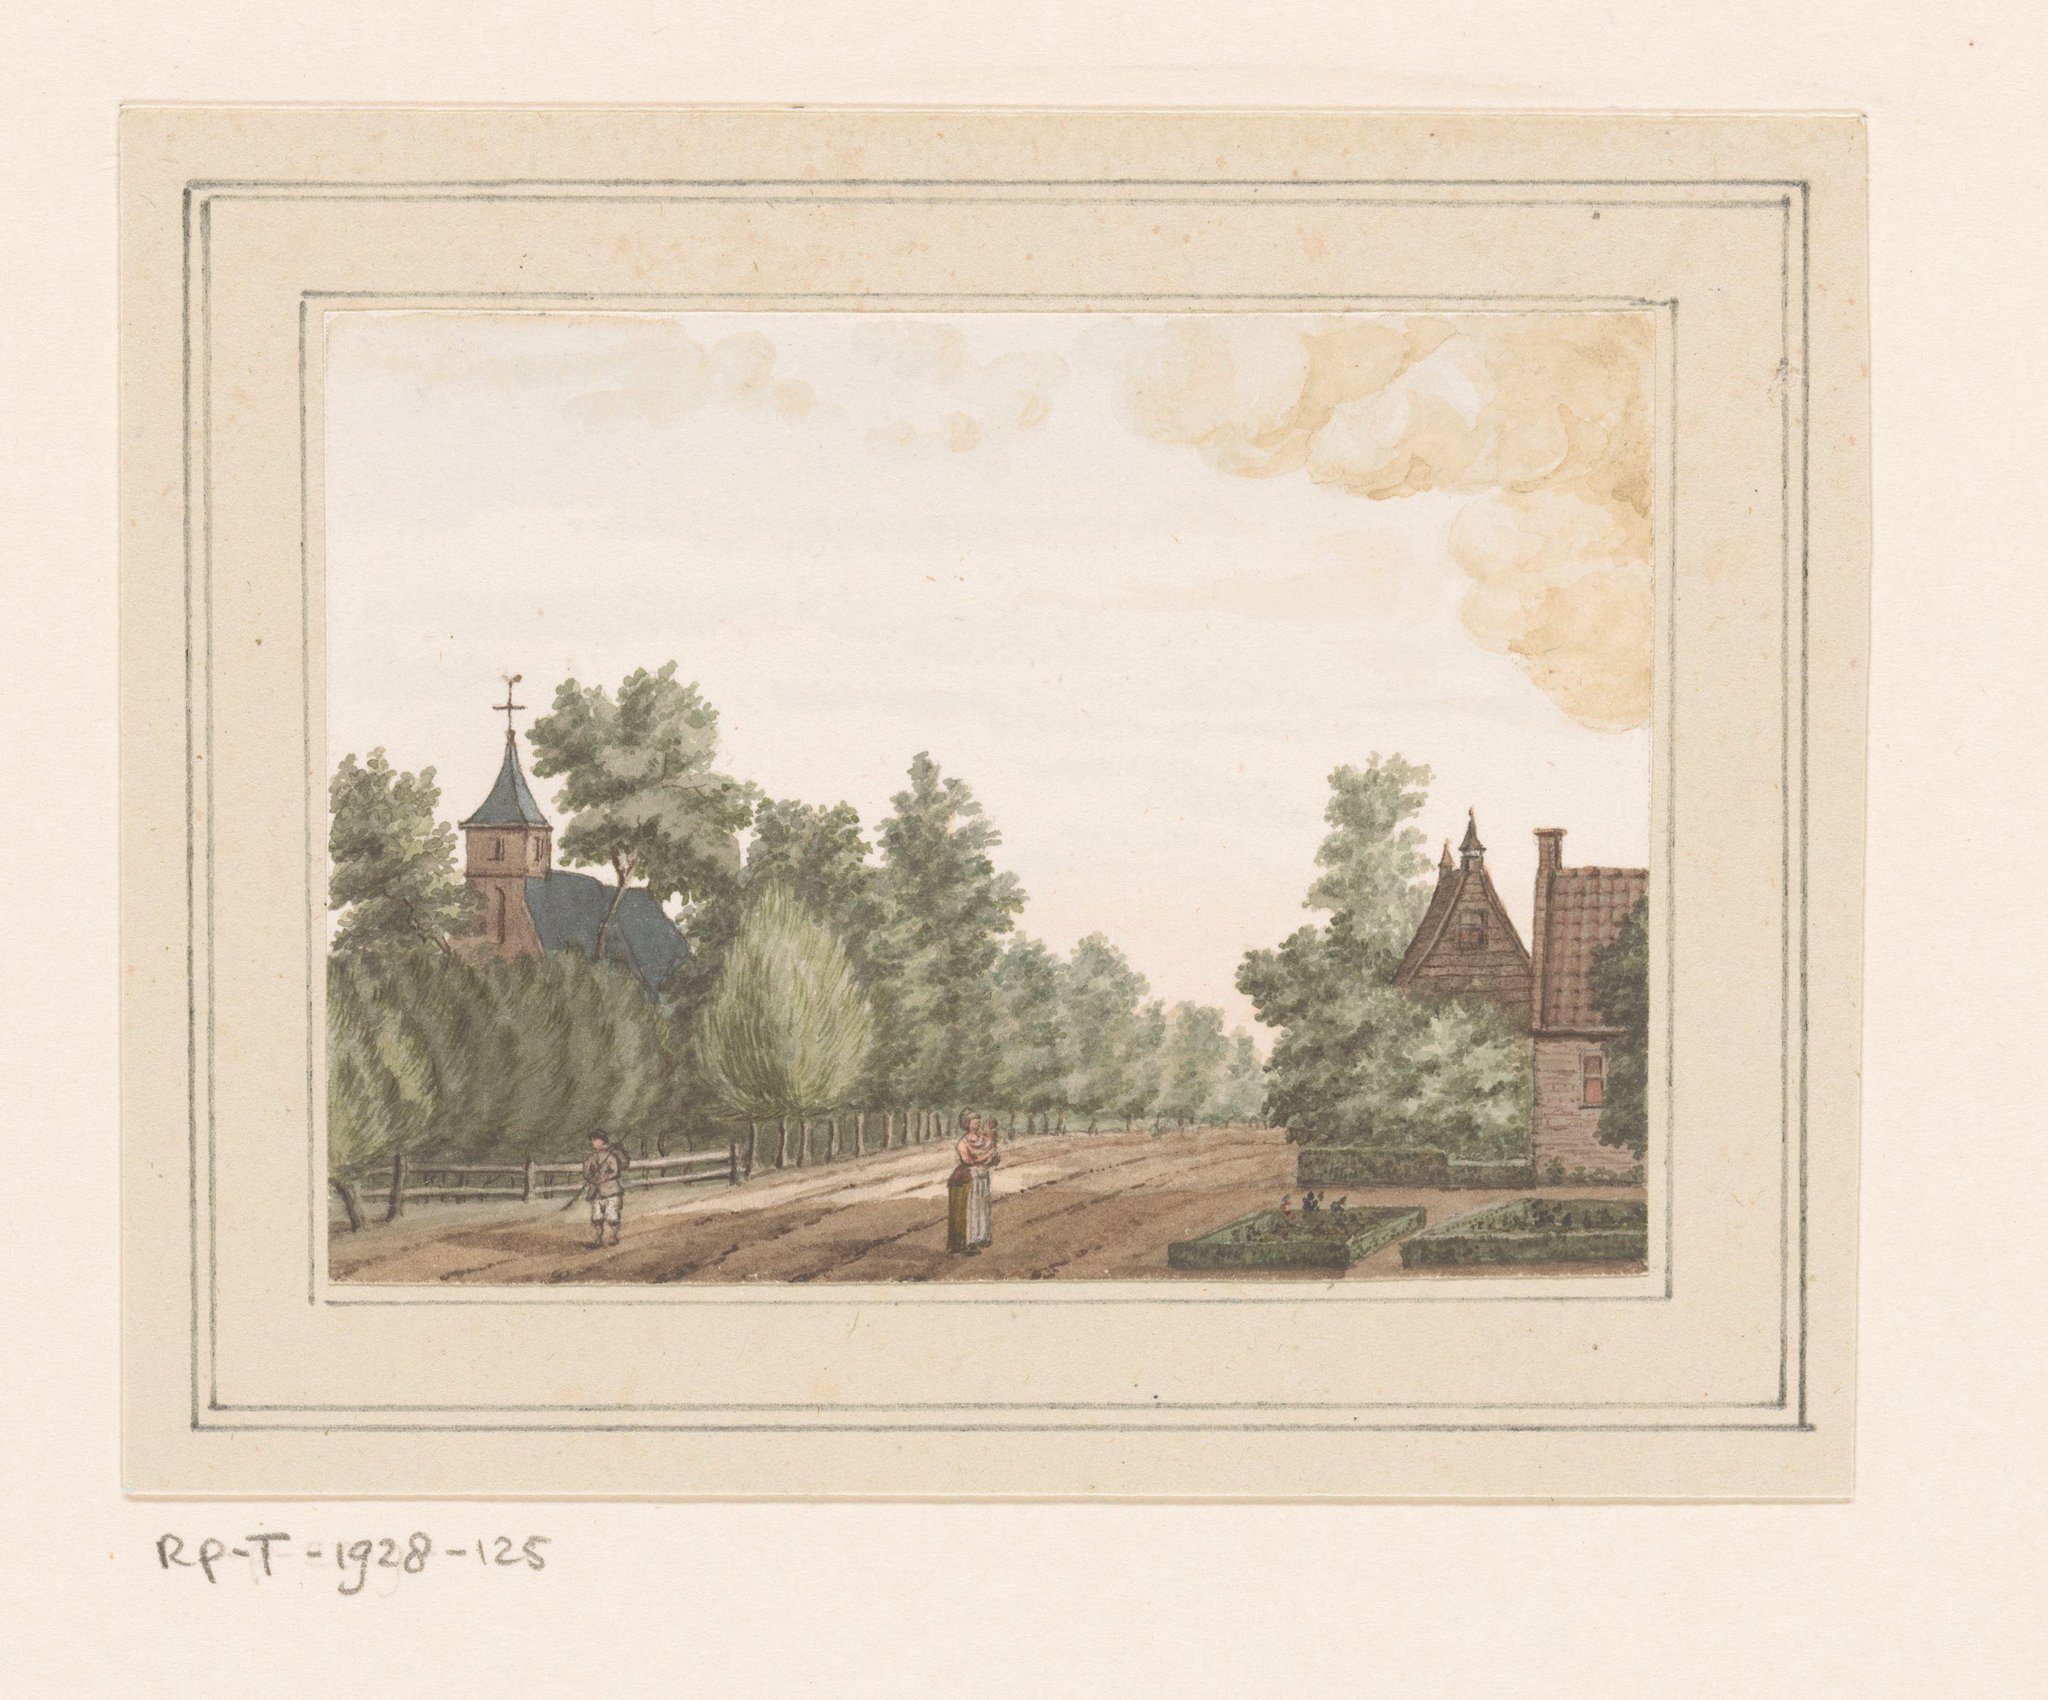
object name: drawing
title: Gezicht op Oud-Loosdrecht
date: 1757-1800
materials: ink, paper, pencil, watercolor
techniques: brush, pen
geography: haarlem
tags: village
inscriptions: inscription: ‘Oude Loosdrecht’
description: Mogelijk een kopie naar de prent van Hendrik Spilman, zie RP-P-AO-8-67-1.